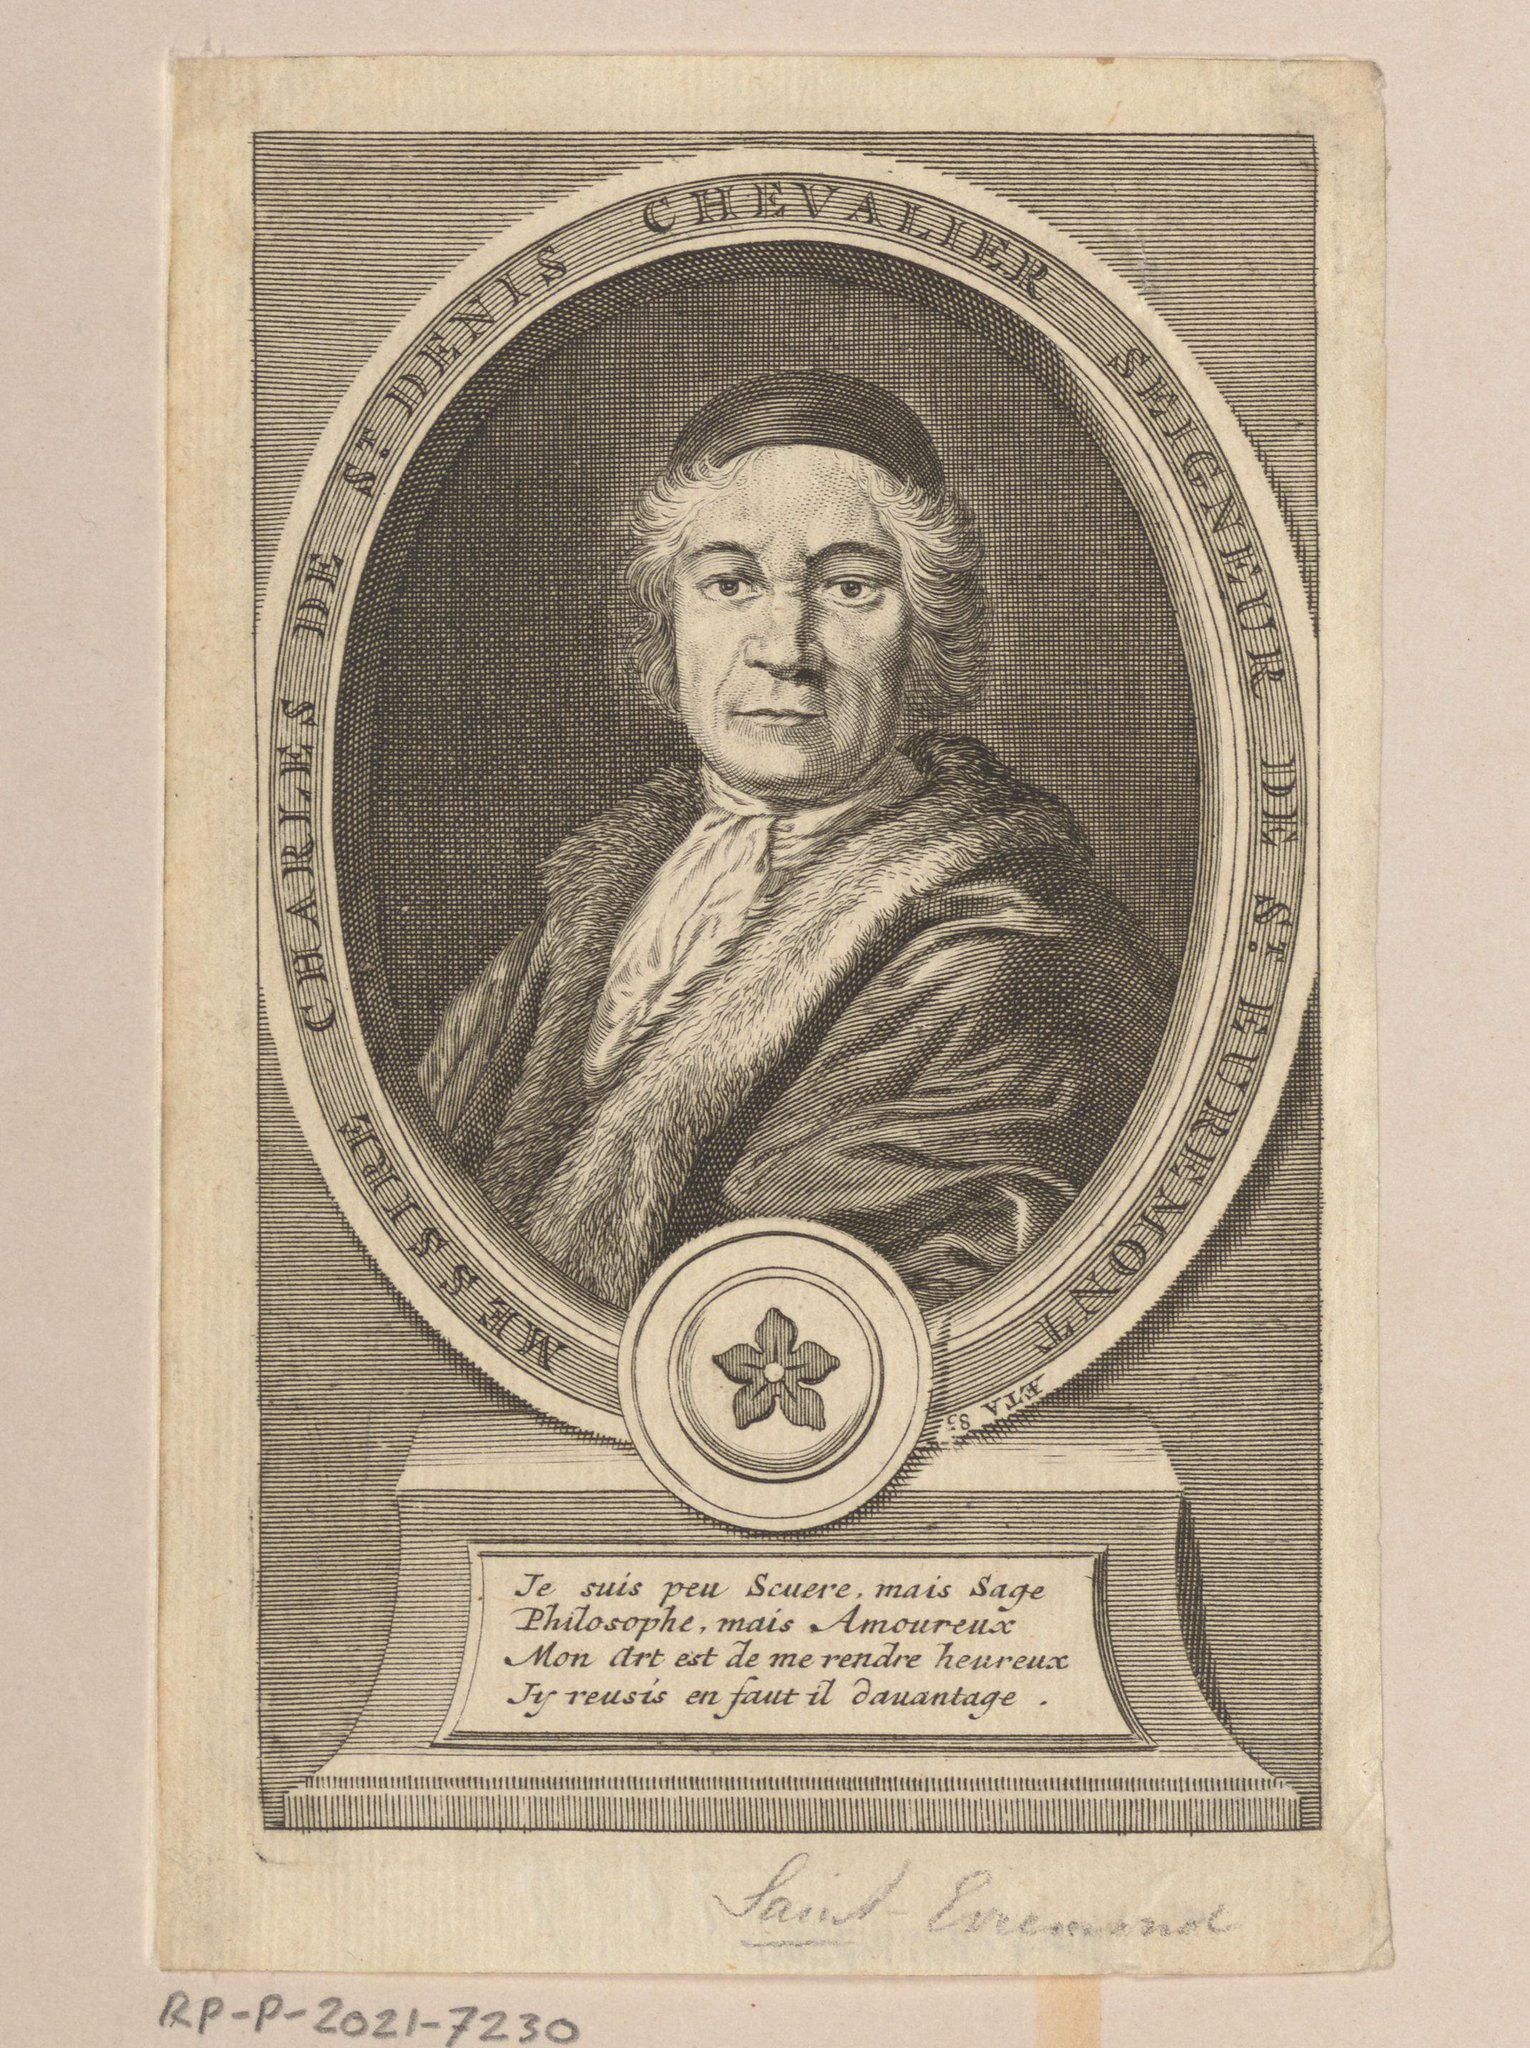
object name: print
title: Portret van Charles de Saint-Évremond op 85-jarige leeftijd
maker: Anonymous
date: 1701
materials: paper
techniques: engraving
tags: military service, historical persons, portrait of a writer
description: Prent mogelijk uit: Saint-Évremond, Charles de. Saint-Évremoniana ou recueil de diverses pièces curieuses (...). Amsterdam: Pierre Mortier, 1701. Latere staat van prent gebruikt in: Les memoires de la vie de comte D avant sa retraite (...). Amsterdam: Pierre Mortier, 1705, dl. 2.